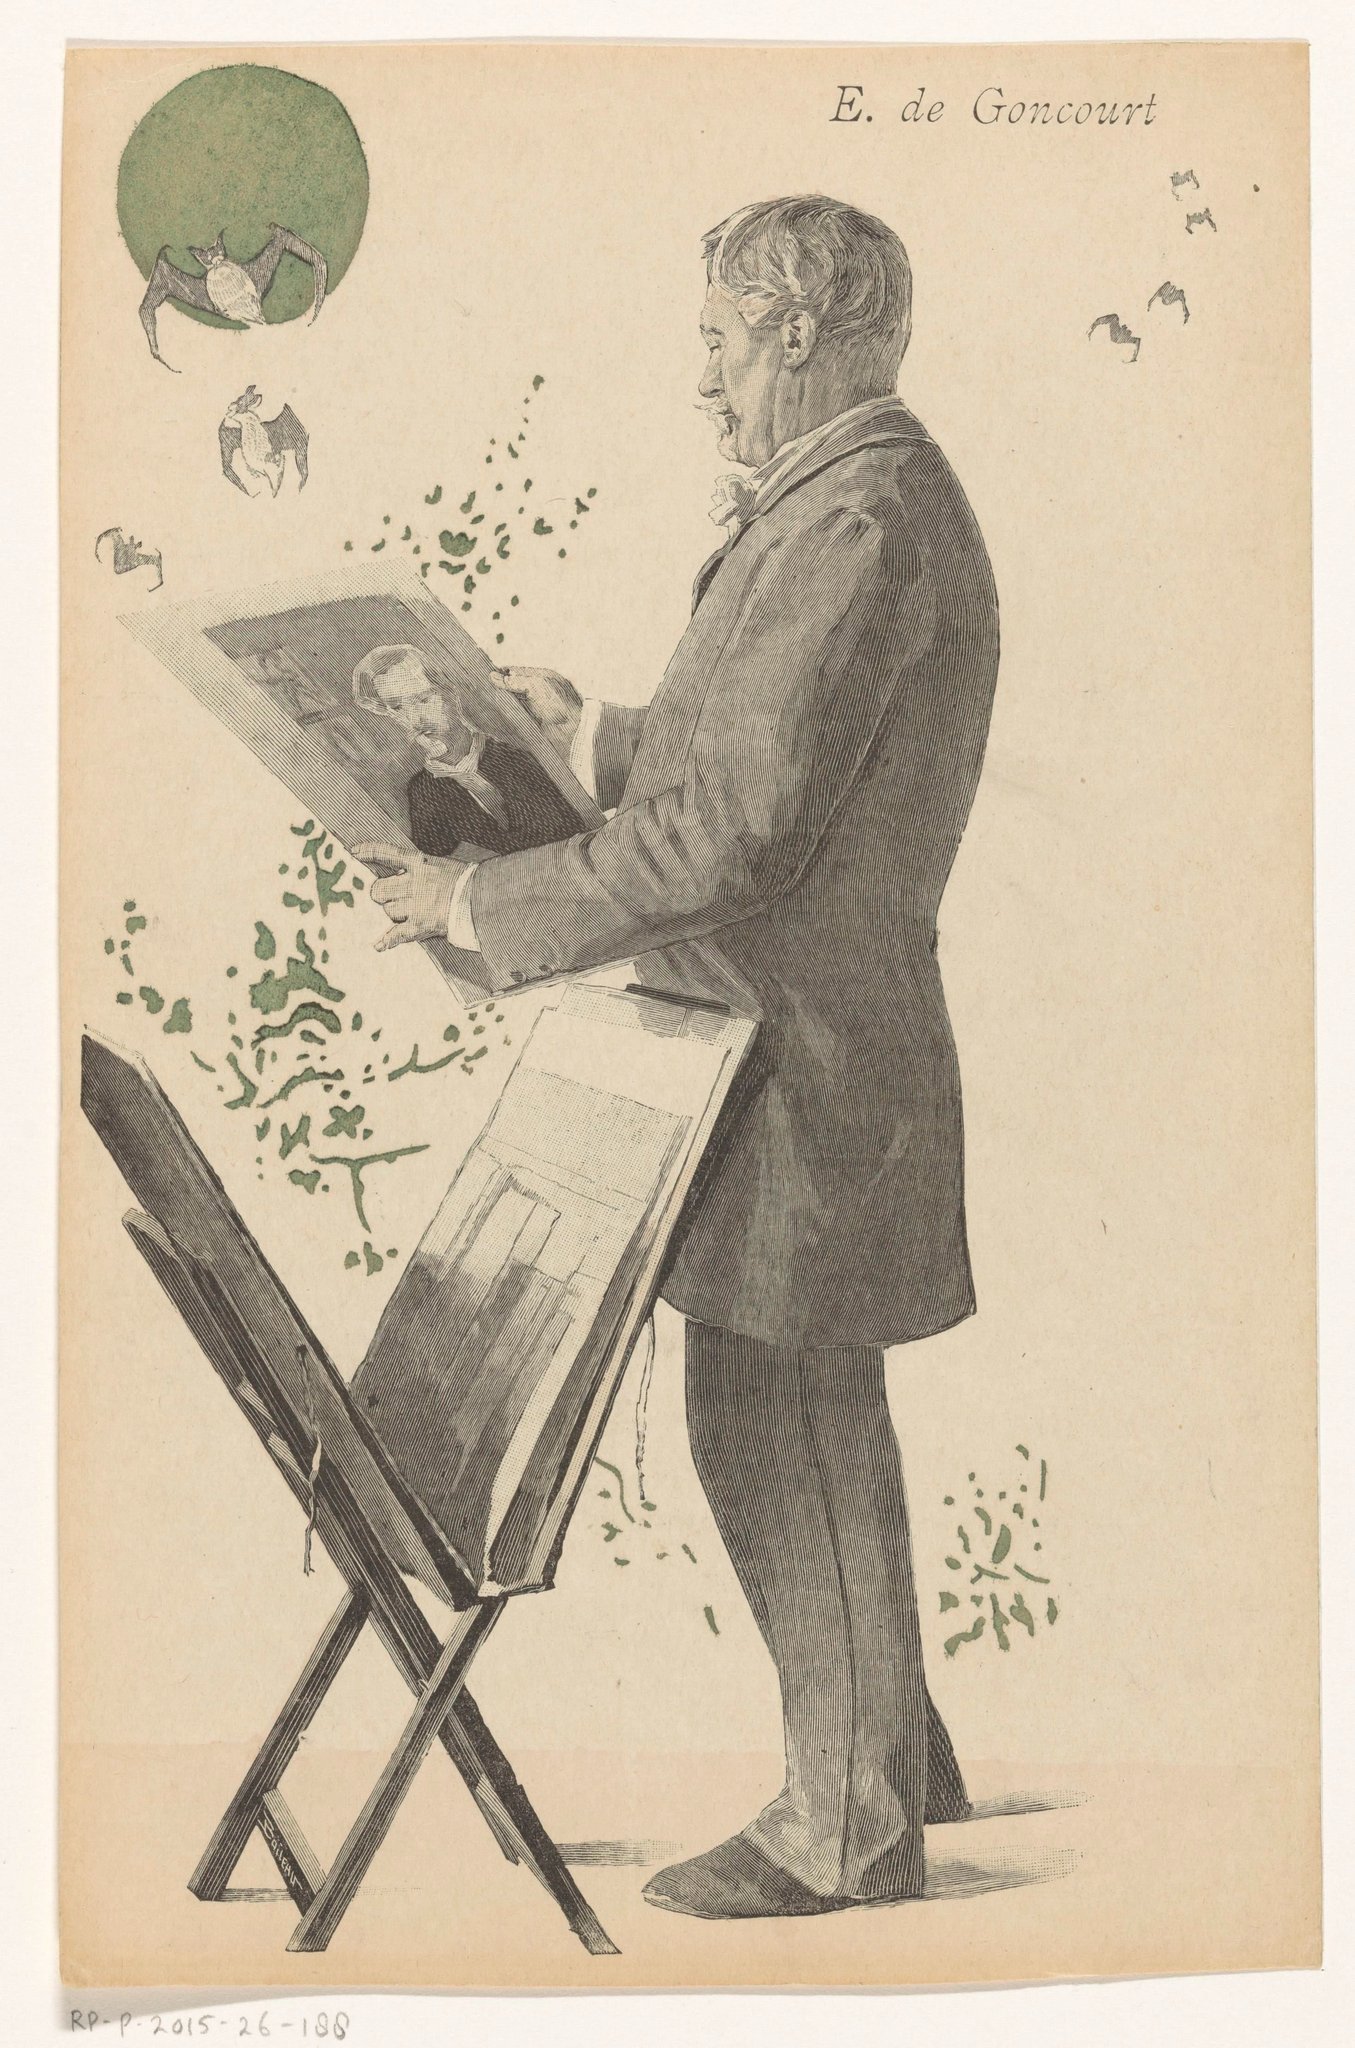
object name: print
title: E. de Goncourt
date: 1888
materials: paper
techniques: printing block, engraving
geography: paris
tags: painter, draughtsman, edmond de goncourt, print, e.g.: engraving, etching, lithograph, historical persons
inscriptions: collector's mark: Lugt 2228, collector's mark: Lugt 4779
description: Mogelijk bekijkt De Goncourt zijn eigen portret. In de lucht vliegen enkele vleermuizen.